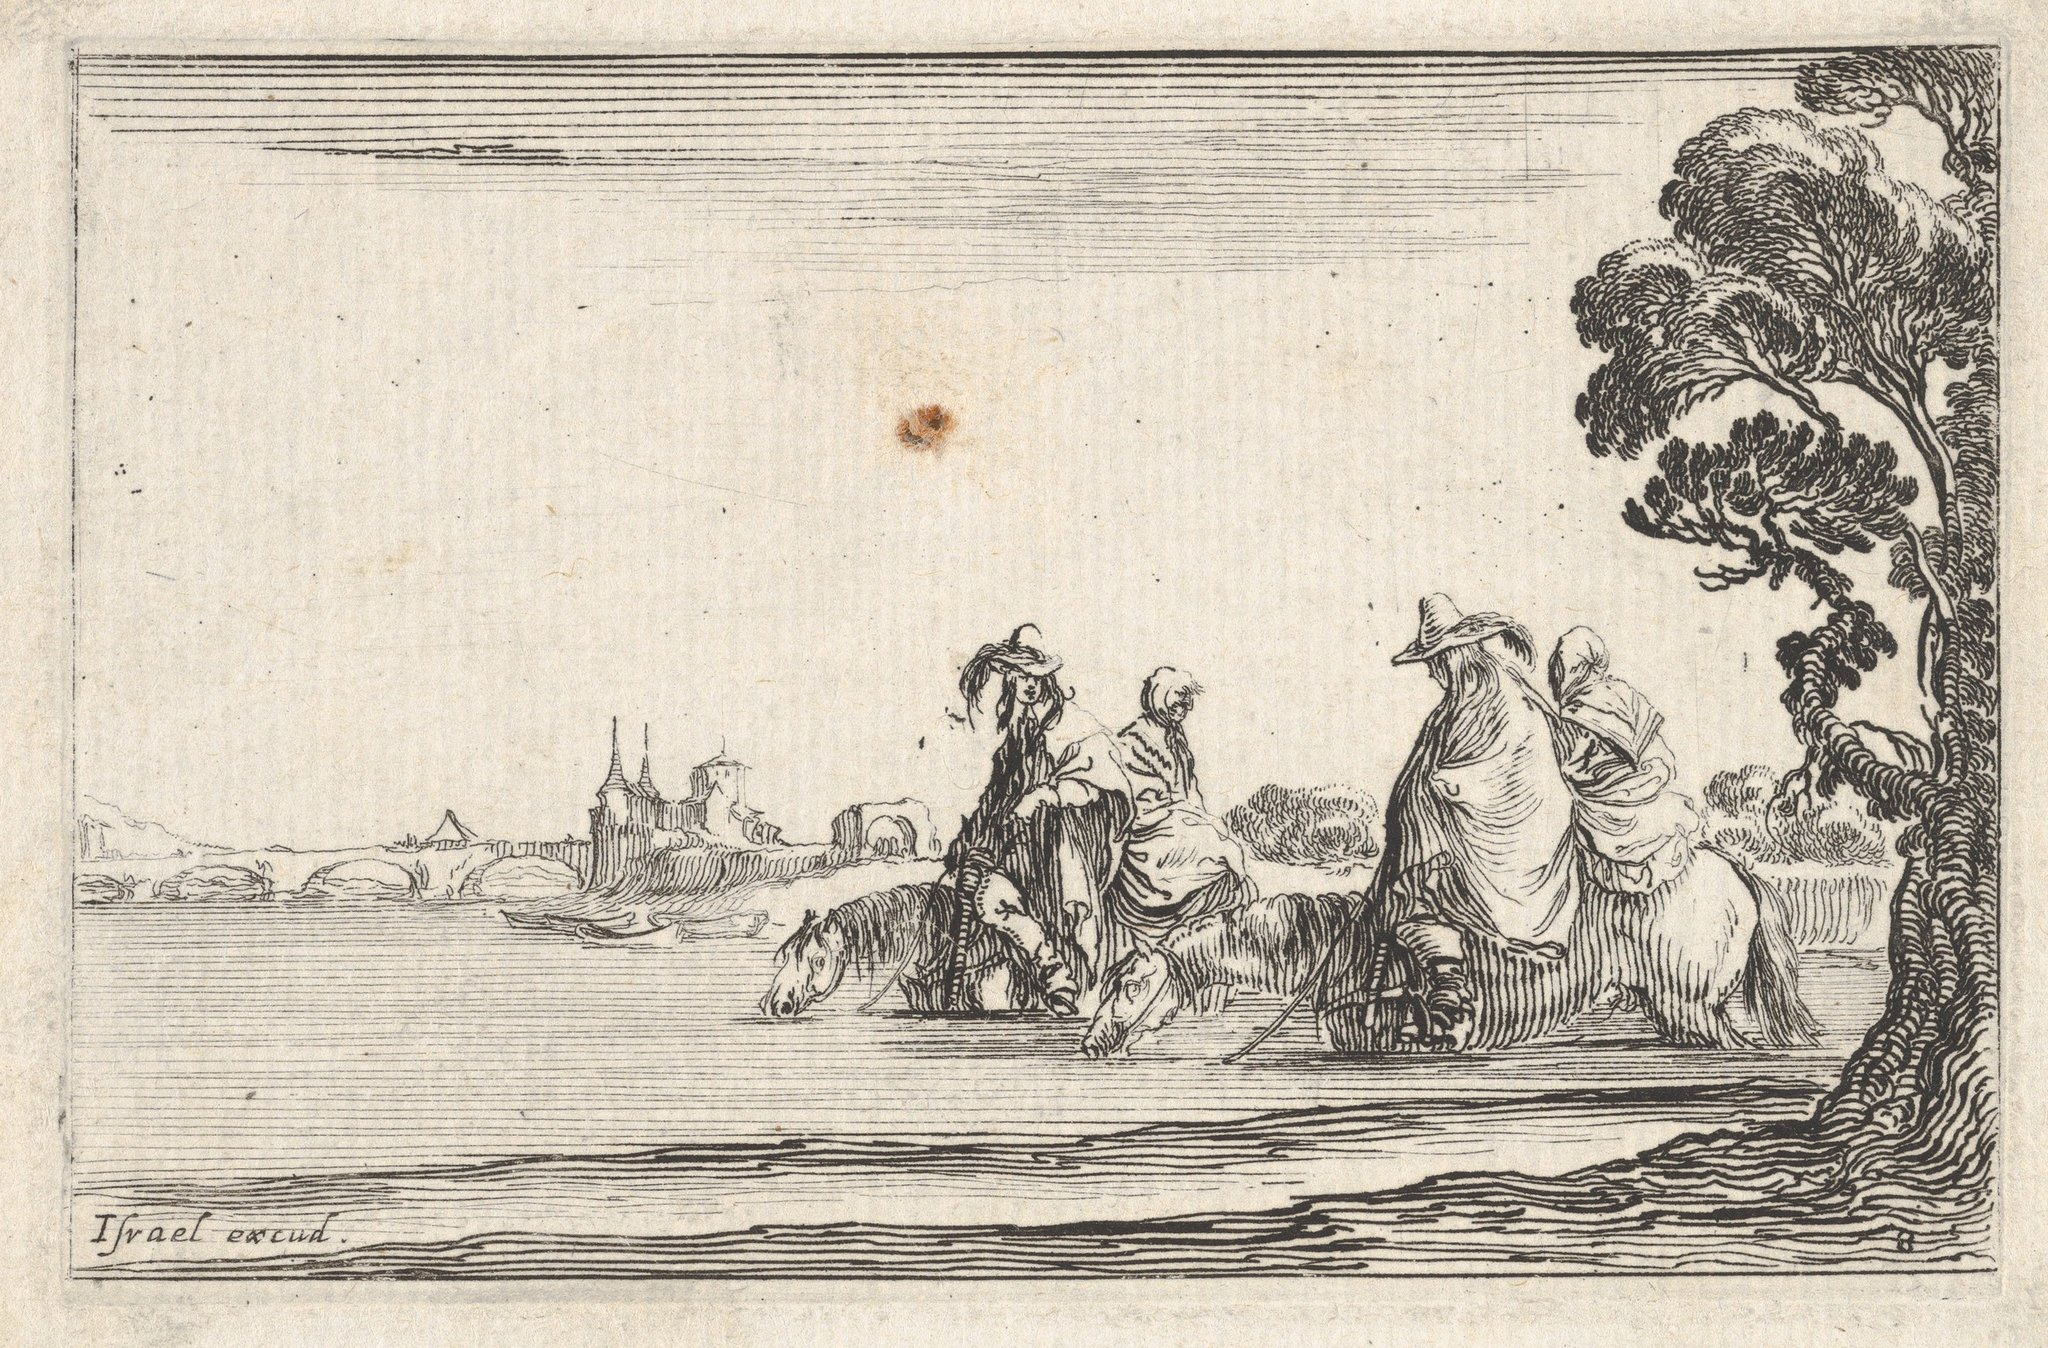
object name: print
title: Plate 8: Two horsemen in hats at right, each with a woman seated behind them, riding towards the left in profile across a river, a tree at far right, from "Caprice faict par de la Bella"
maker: stefano della bella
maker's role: artist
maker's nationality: italian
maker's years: 1610-1664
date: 1642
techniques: etching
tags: men,women,horses,rivers,trees